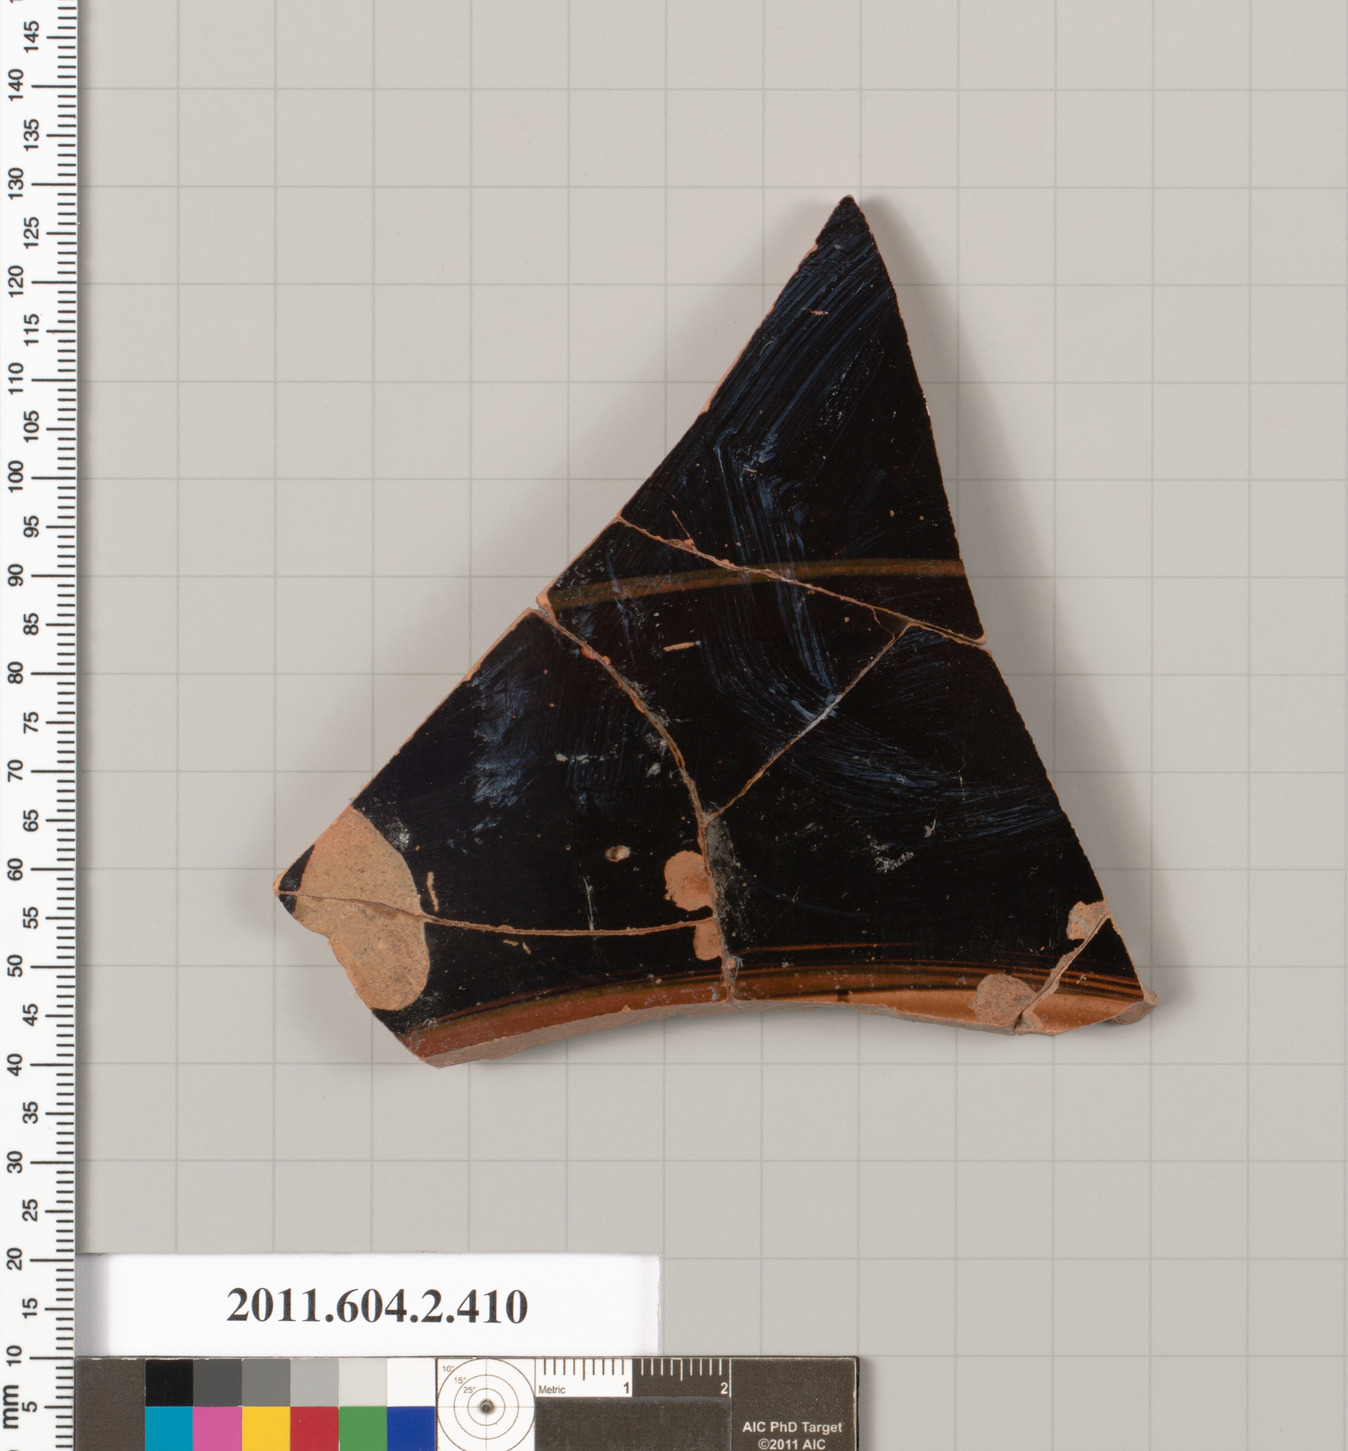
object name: column krater fragment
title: Terracotta fragment of a column-krater (bowl for mixing wine and water)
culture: greek, attic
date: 460-440 BCE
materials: terracotta